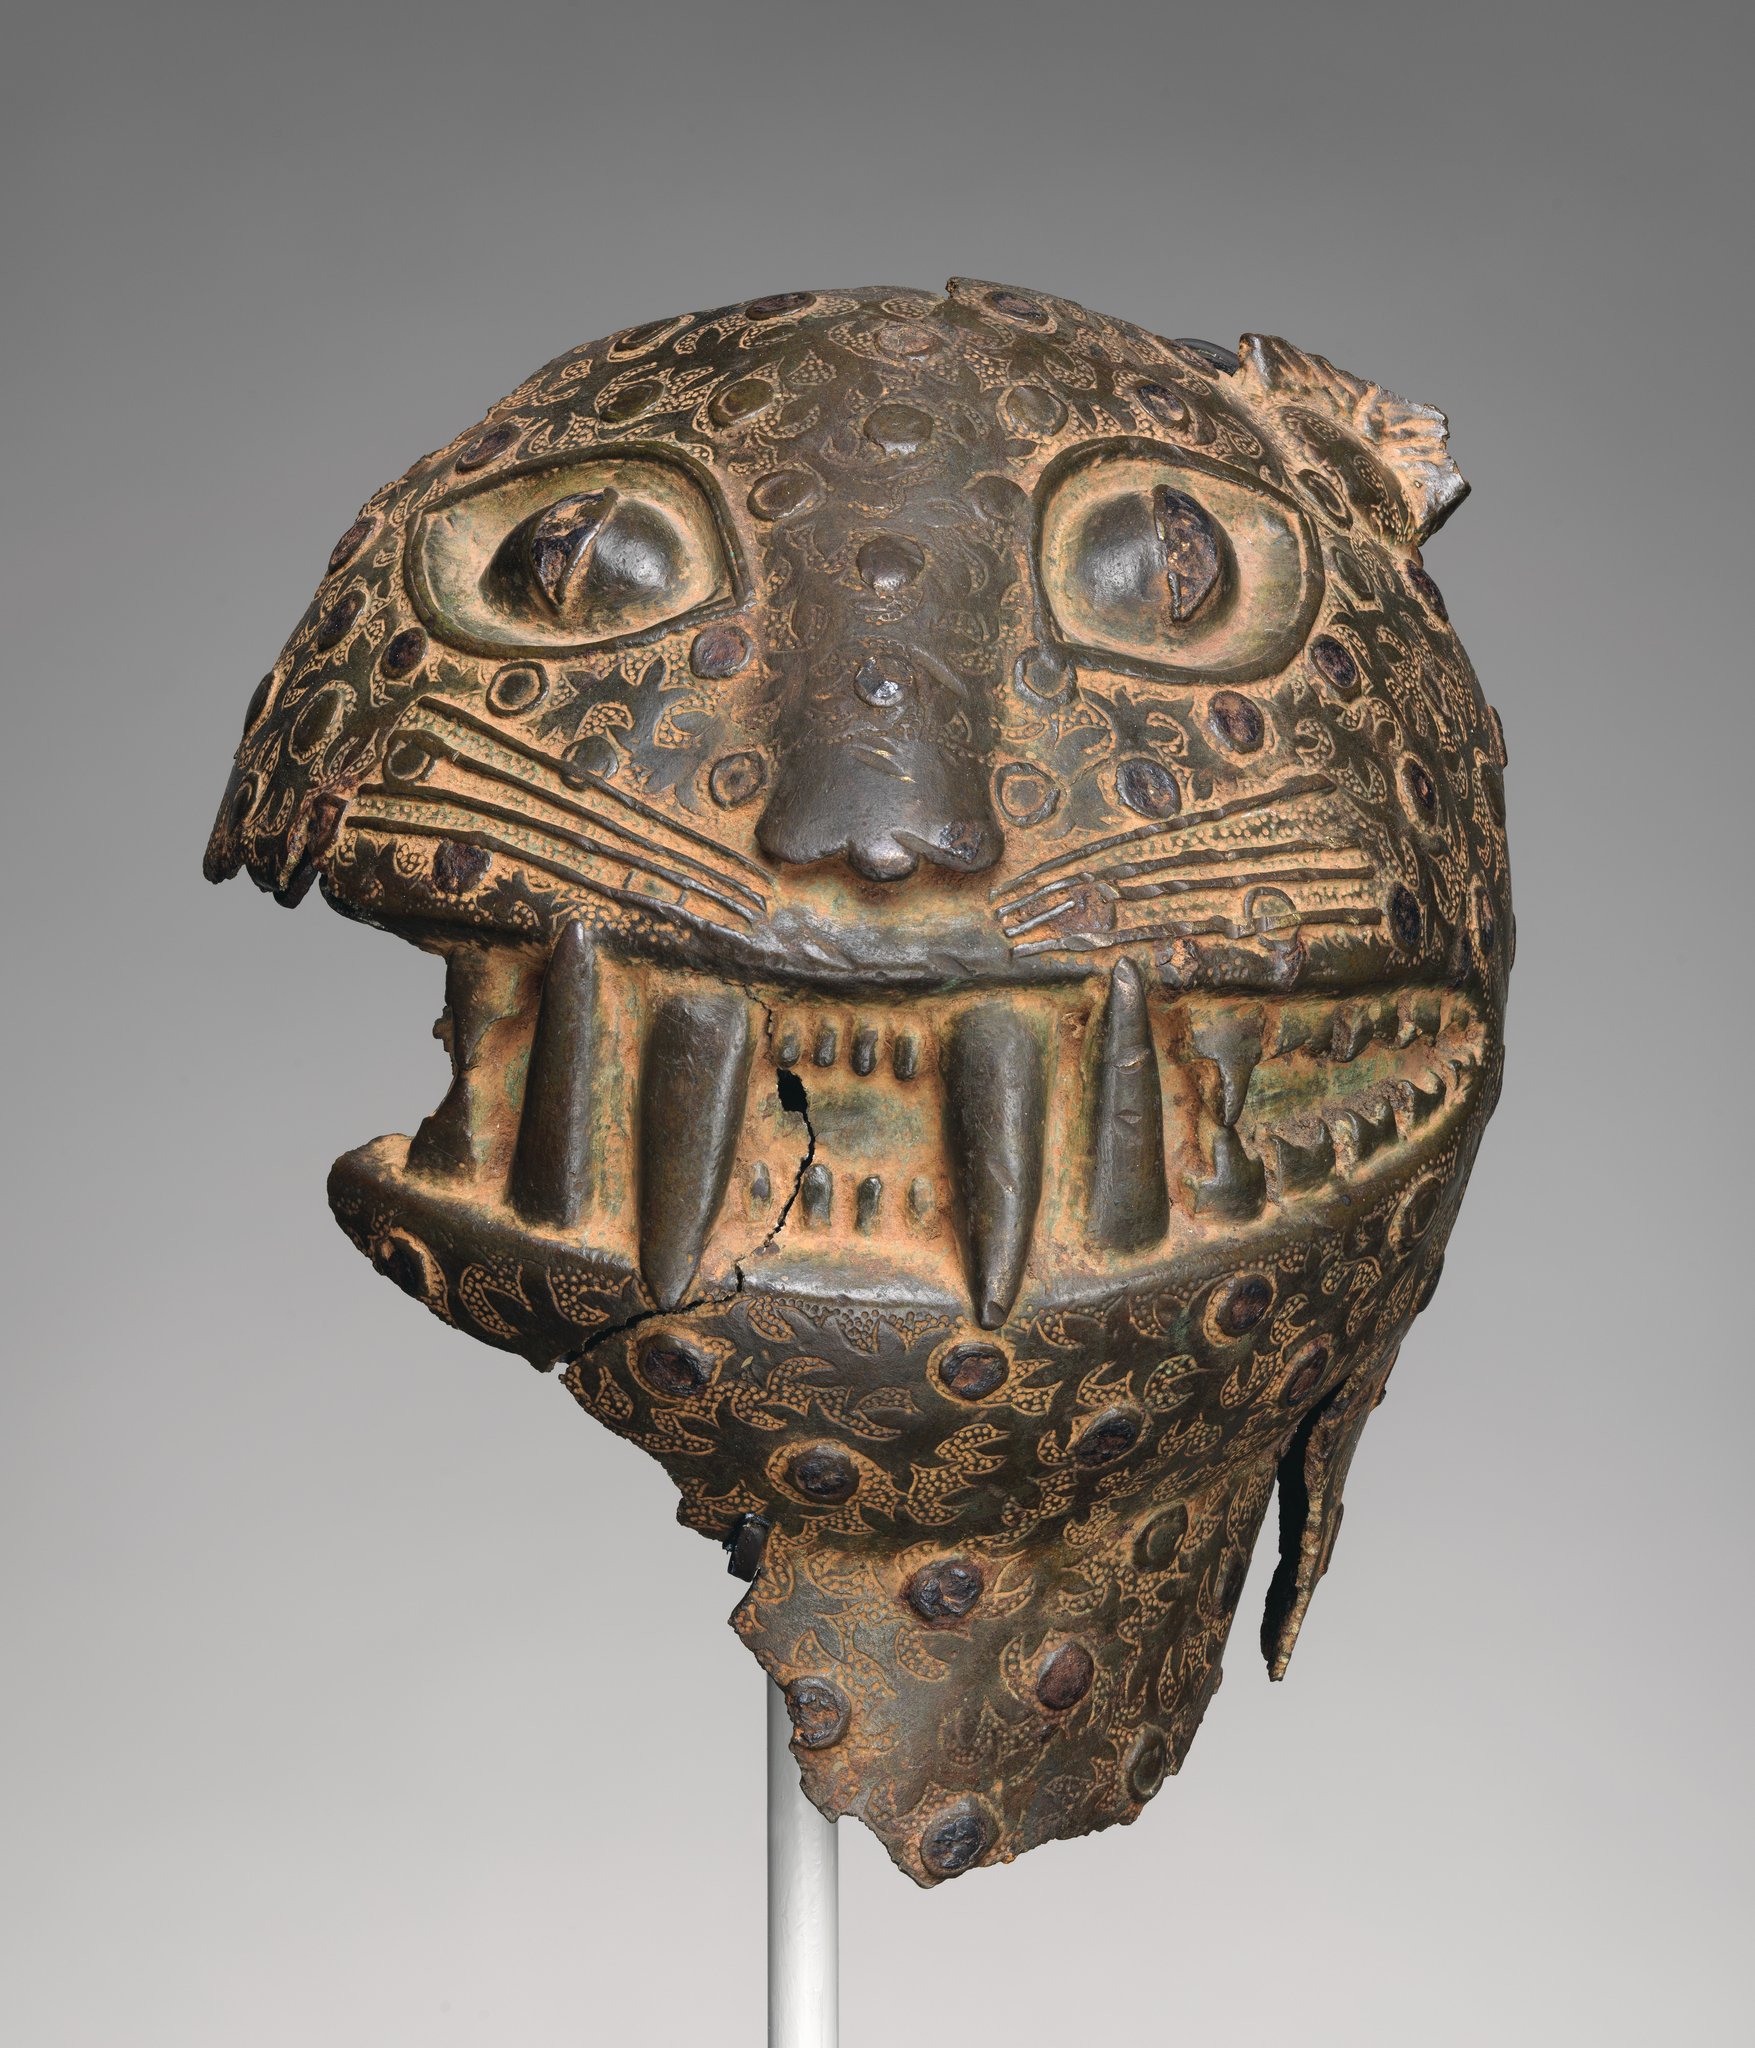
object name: head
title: Fragment of a leopard head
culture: edo period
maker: ìgùn ẹ́rọ̀nwwọ̀n (brass-casting guild) artists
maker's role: artist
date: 1601-1633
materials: brass, pigment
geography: nigeria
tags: leopards